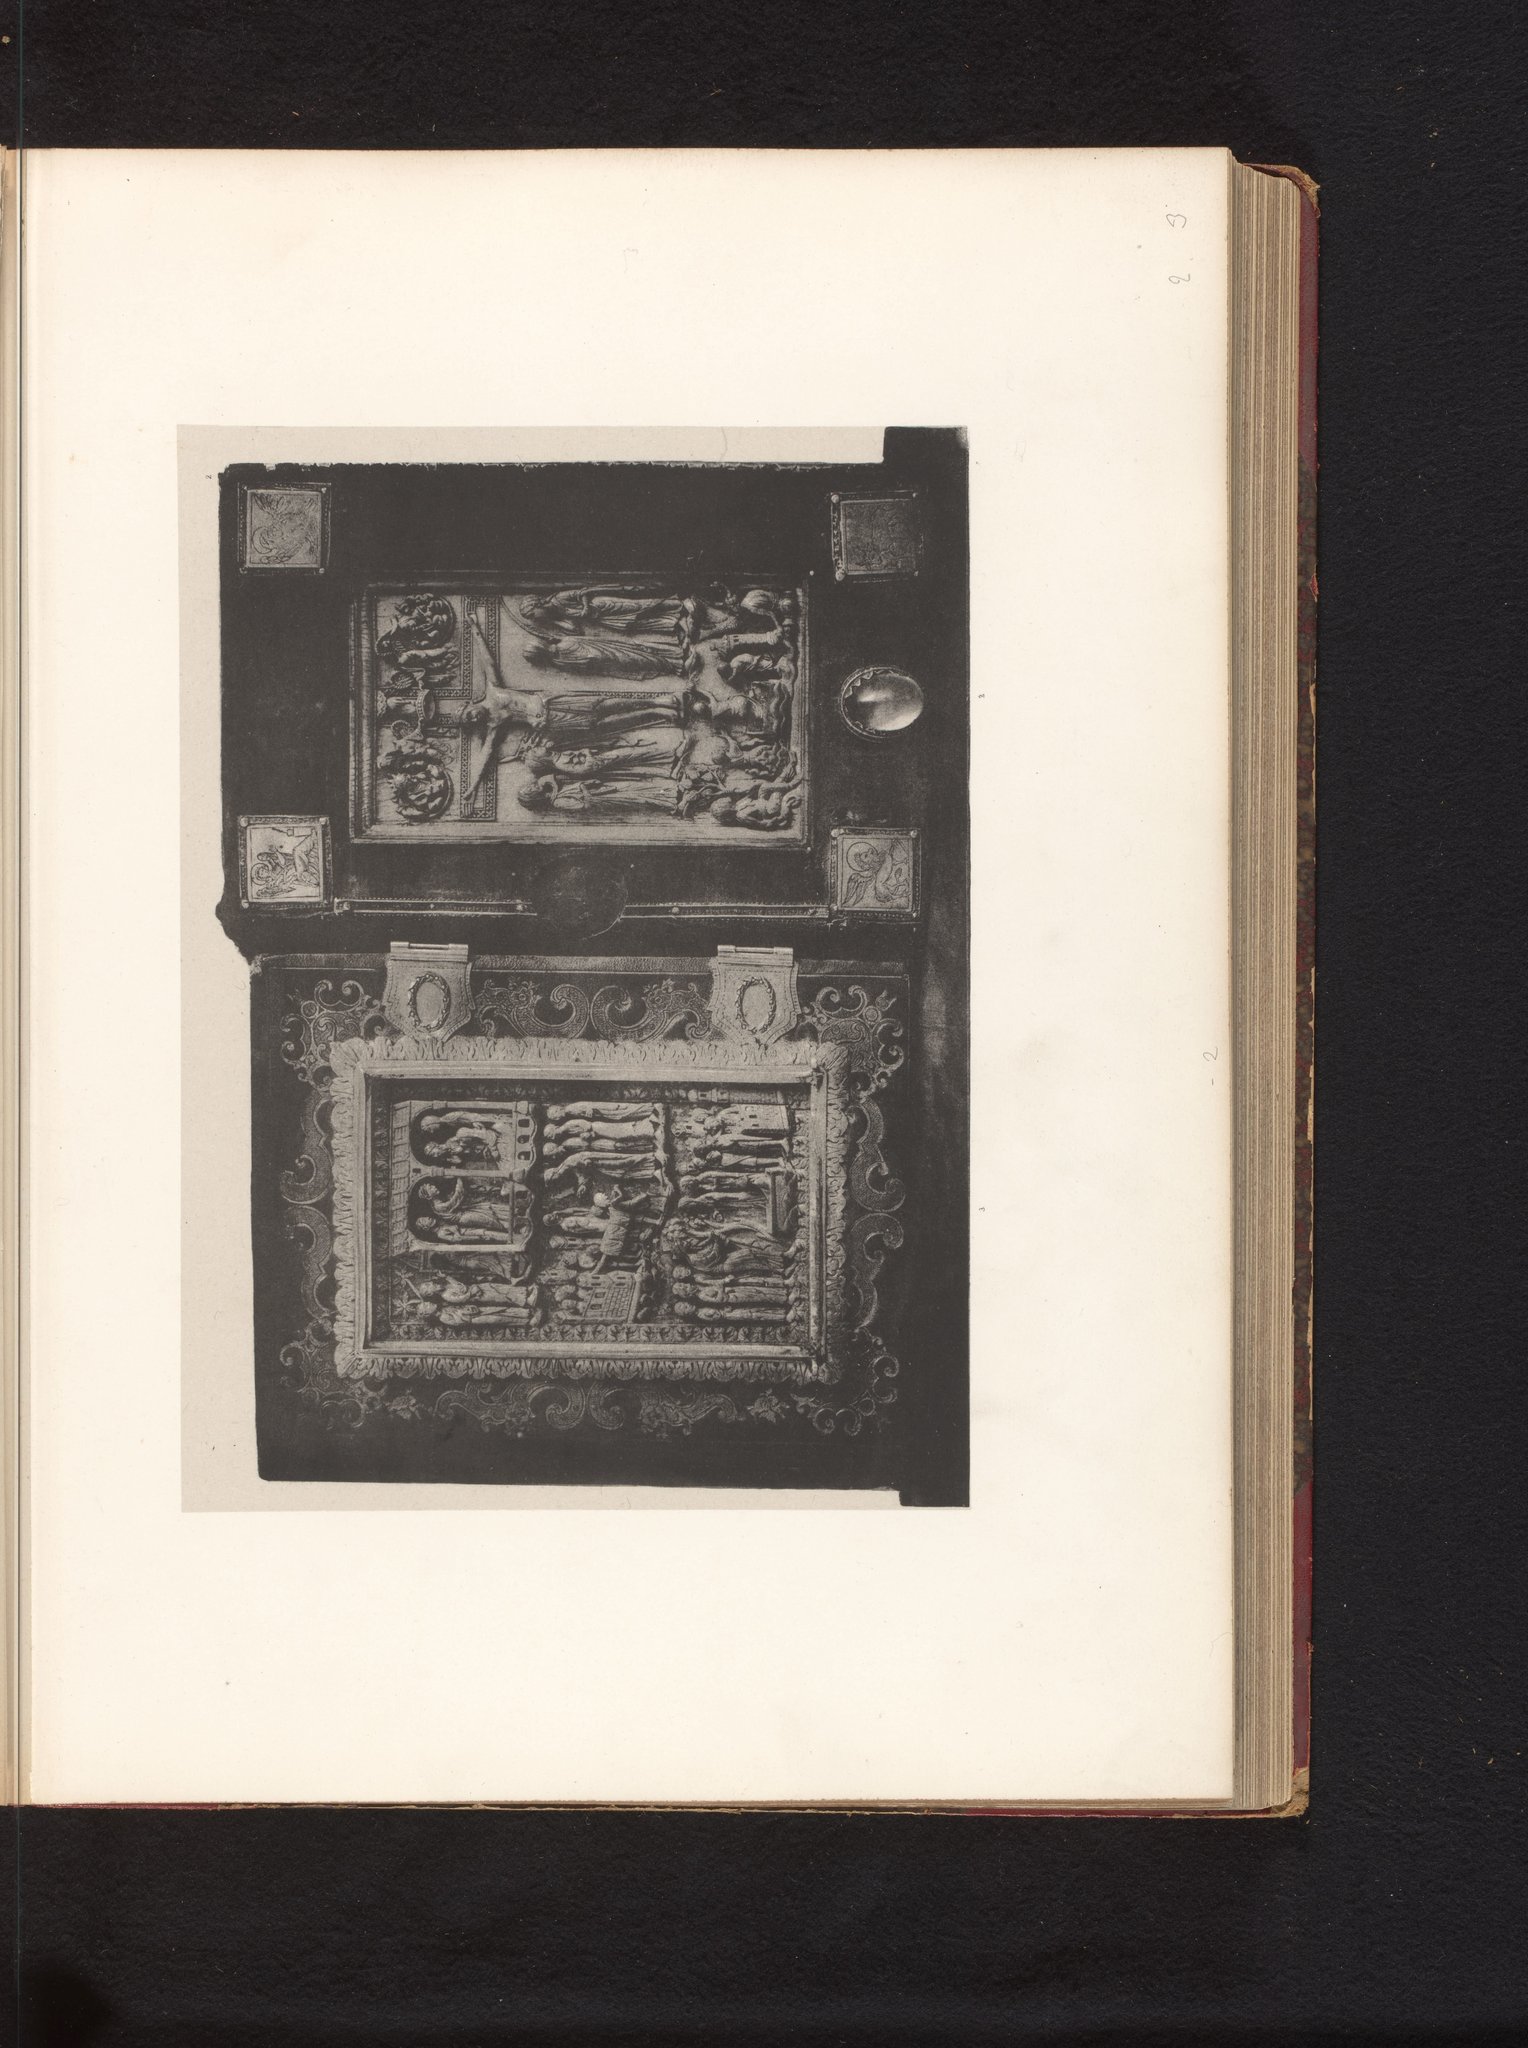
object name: page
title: Twee reliëfs van ivoor met voorstellingen uit het Nieuwe Testament, uit de Onze-Lieve-Vrouwebasiliek in Tongeren en de Sint-Pauluskathedraal in Luik, opgesteld op een tentoonstelling over religieuze objecten uit de middeleeuwen en renaissance in 1864 in Mechelen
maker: joseph maes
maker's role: fotograaf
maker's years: 1838-1908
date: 1864-1866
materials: paper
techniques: photolithography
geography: mechelen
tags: piece of sculpture, reproduction of a piece of sculpture (+ bone, ivory ~ arts), new testament, mechelen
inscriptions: number: ‘3 - 2’, number: ‘-2’, number: ‘2. 3’